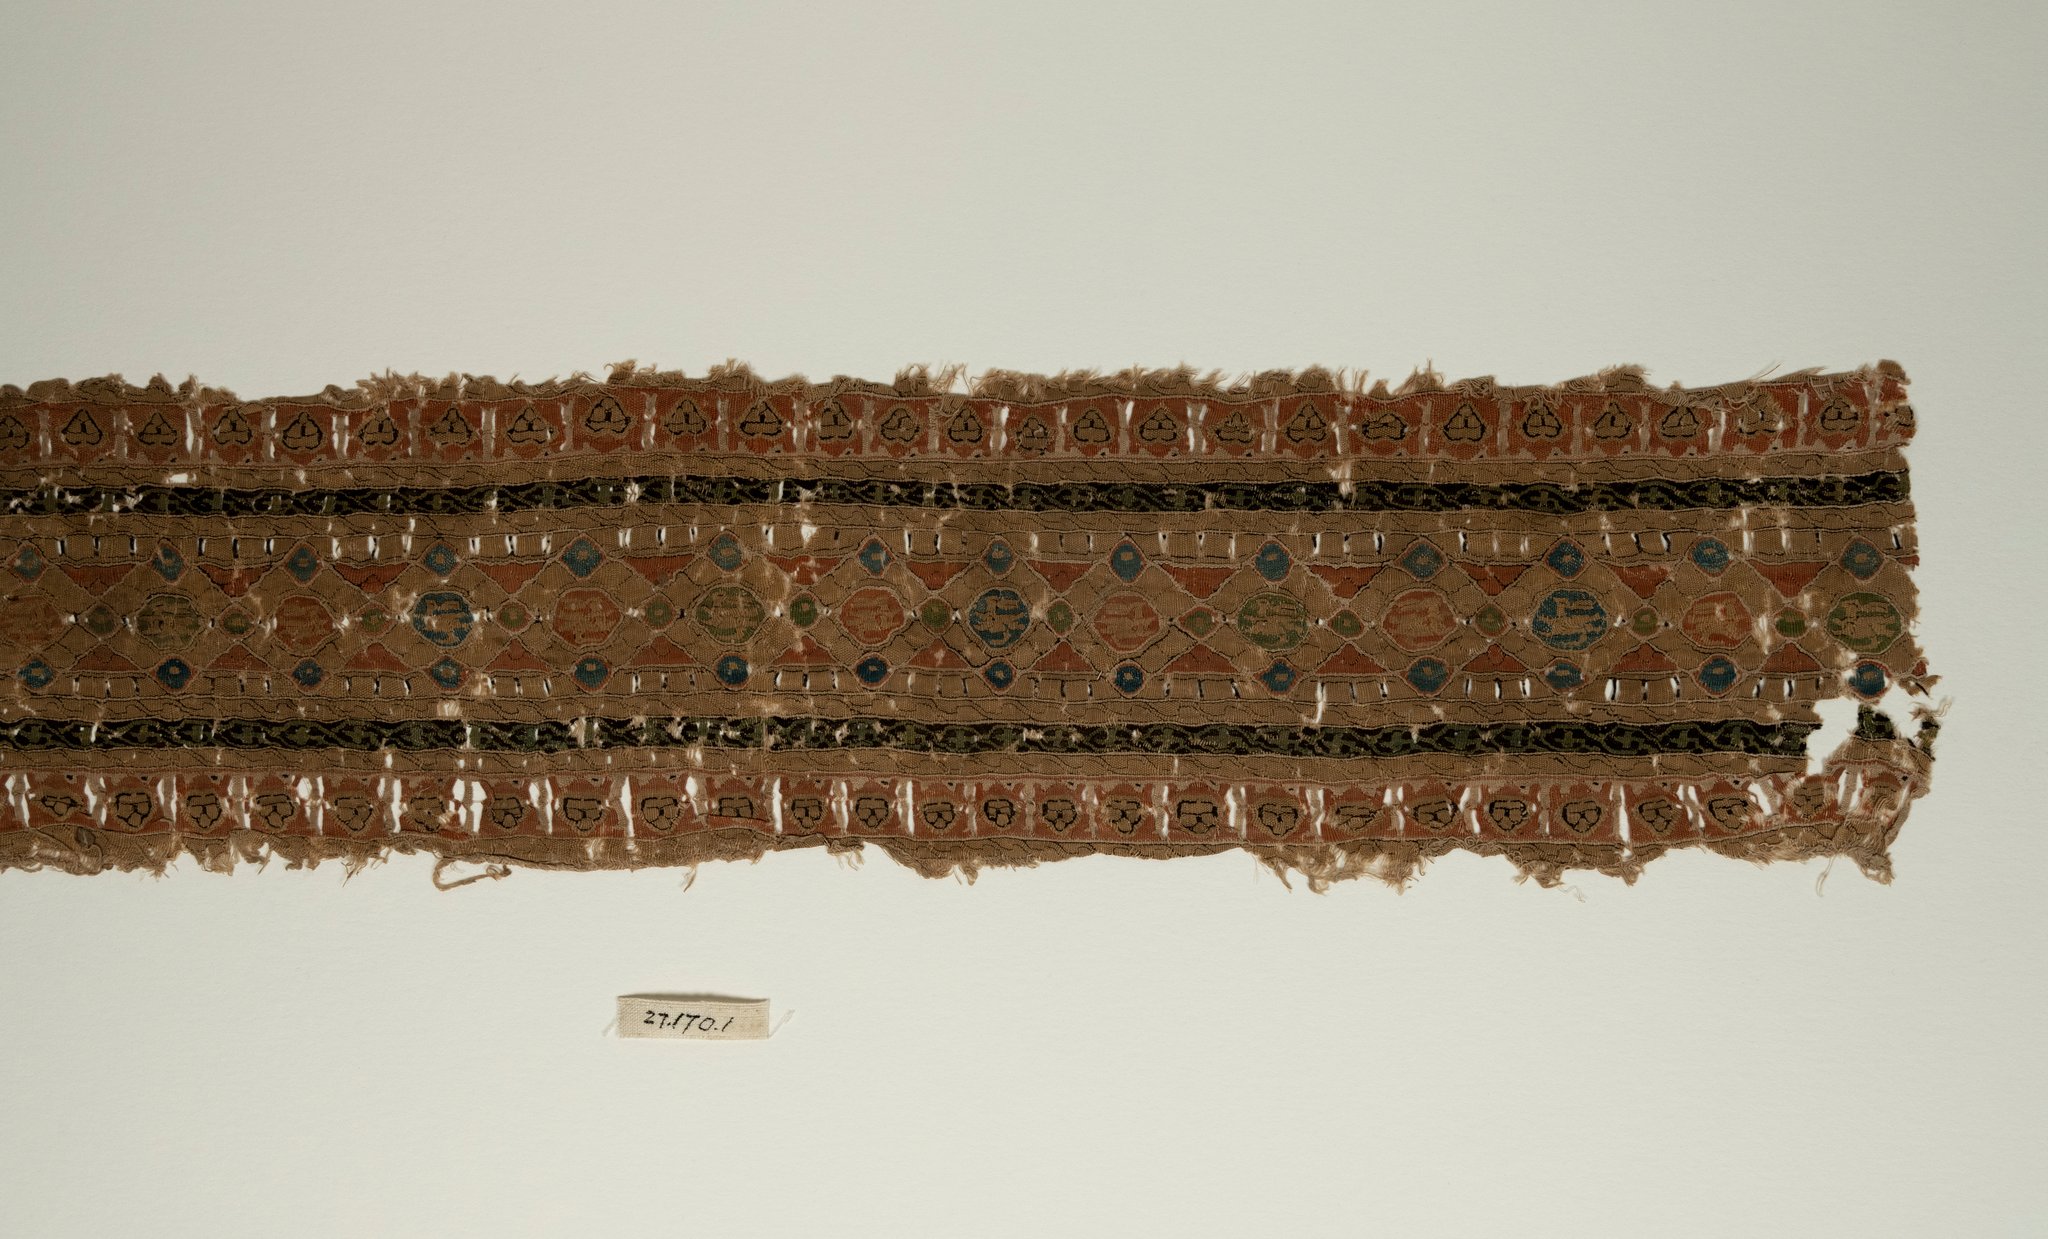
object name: textile fragment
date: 1067-1100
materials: cotton, silk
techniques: weave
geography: egypt